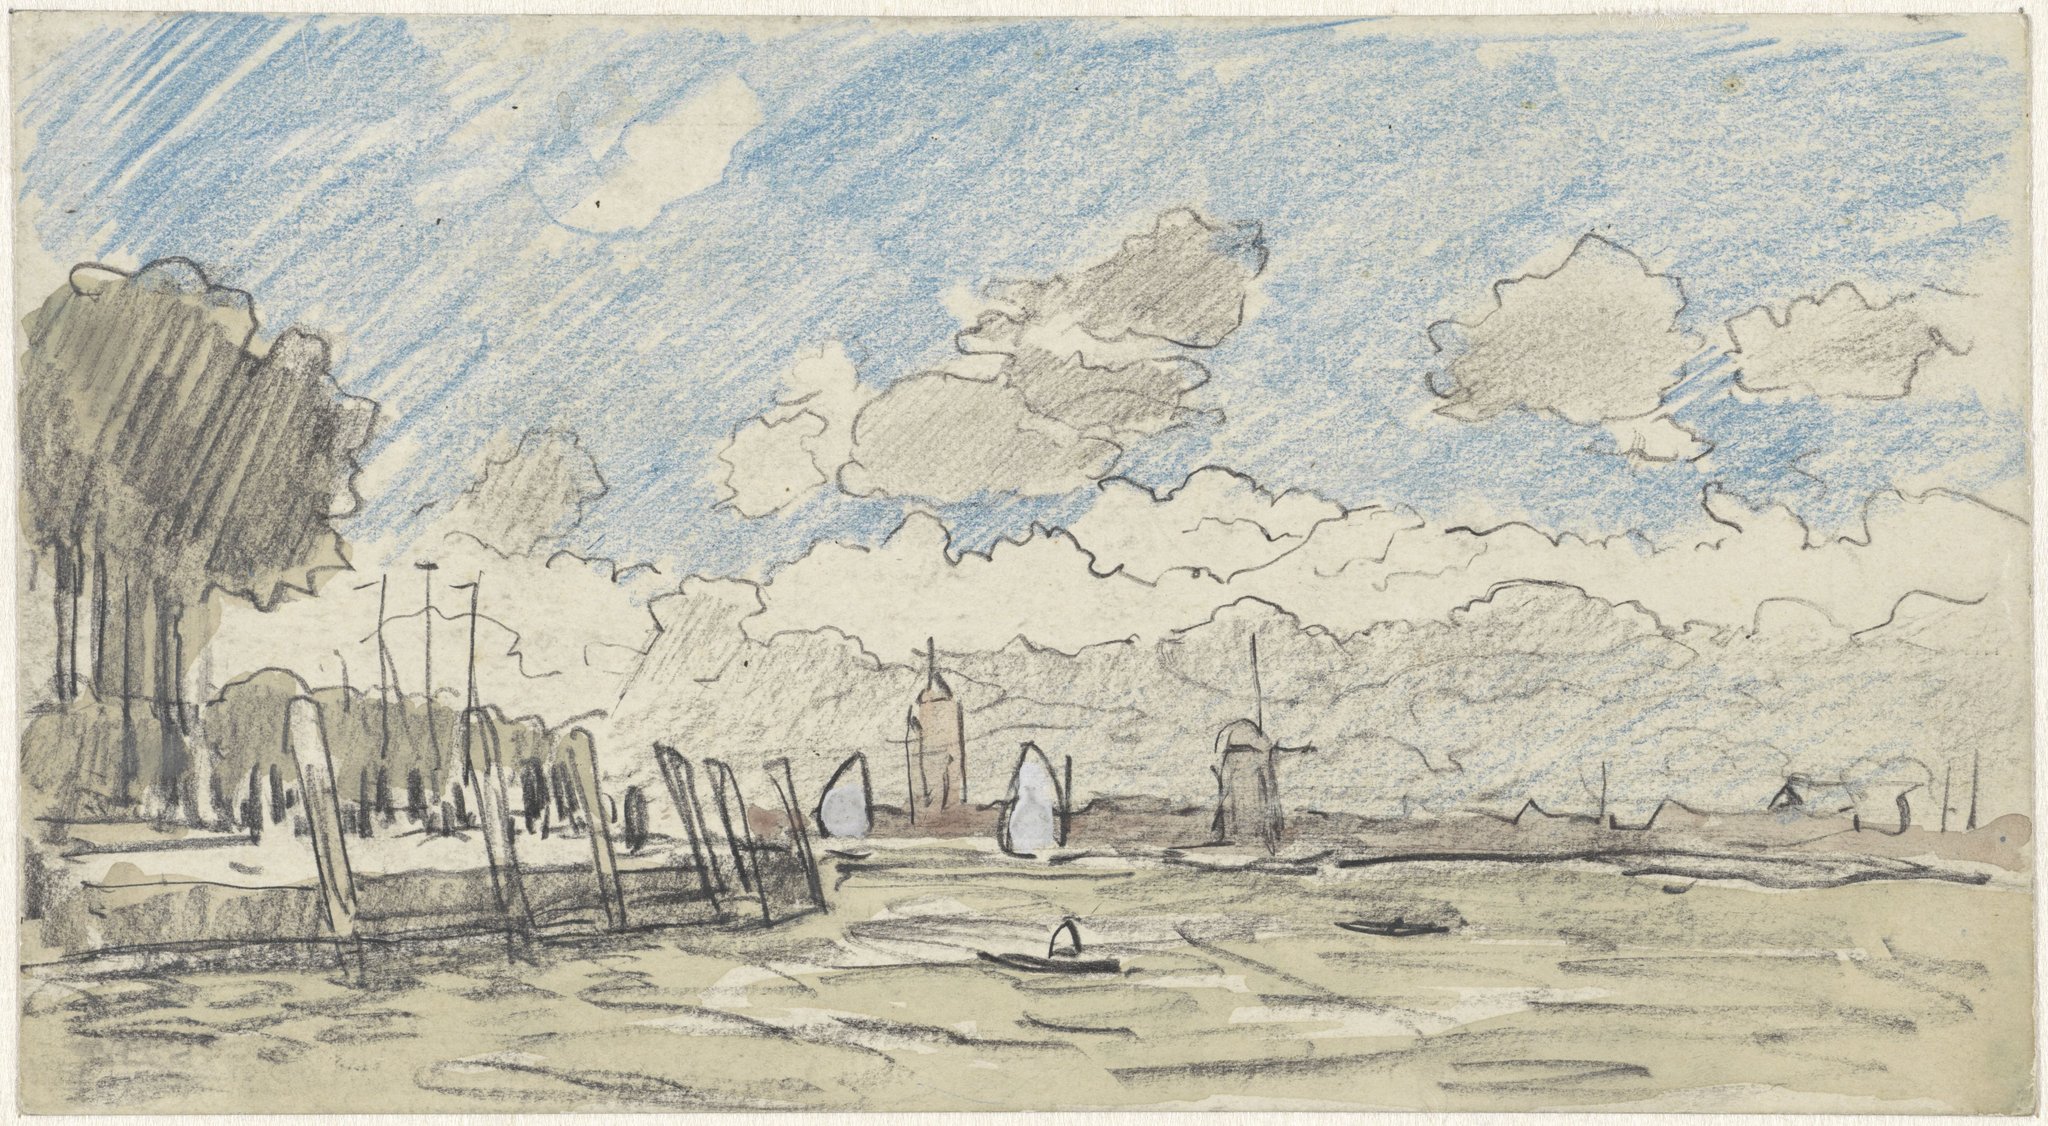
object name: drawing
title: Stadje aan het water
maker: adolf le comte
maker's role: draughtsman, painter, print maker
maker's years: 1850-1921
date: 1860-1921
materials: chalk, paper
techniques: brush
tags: quay